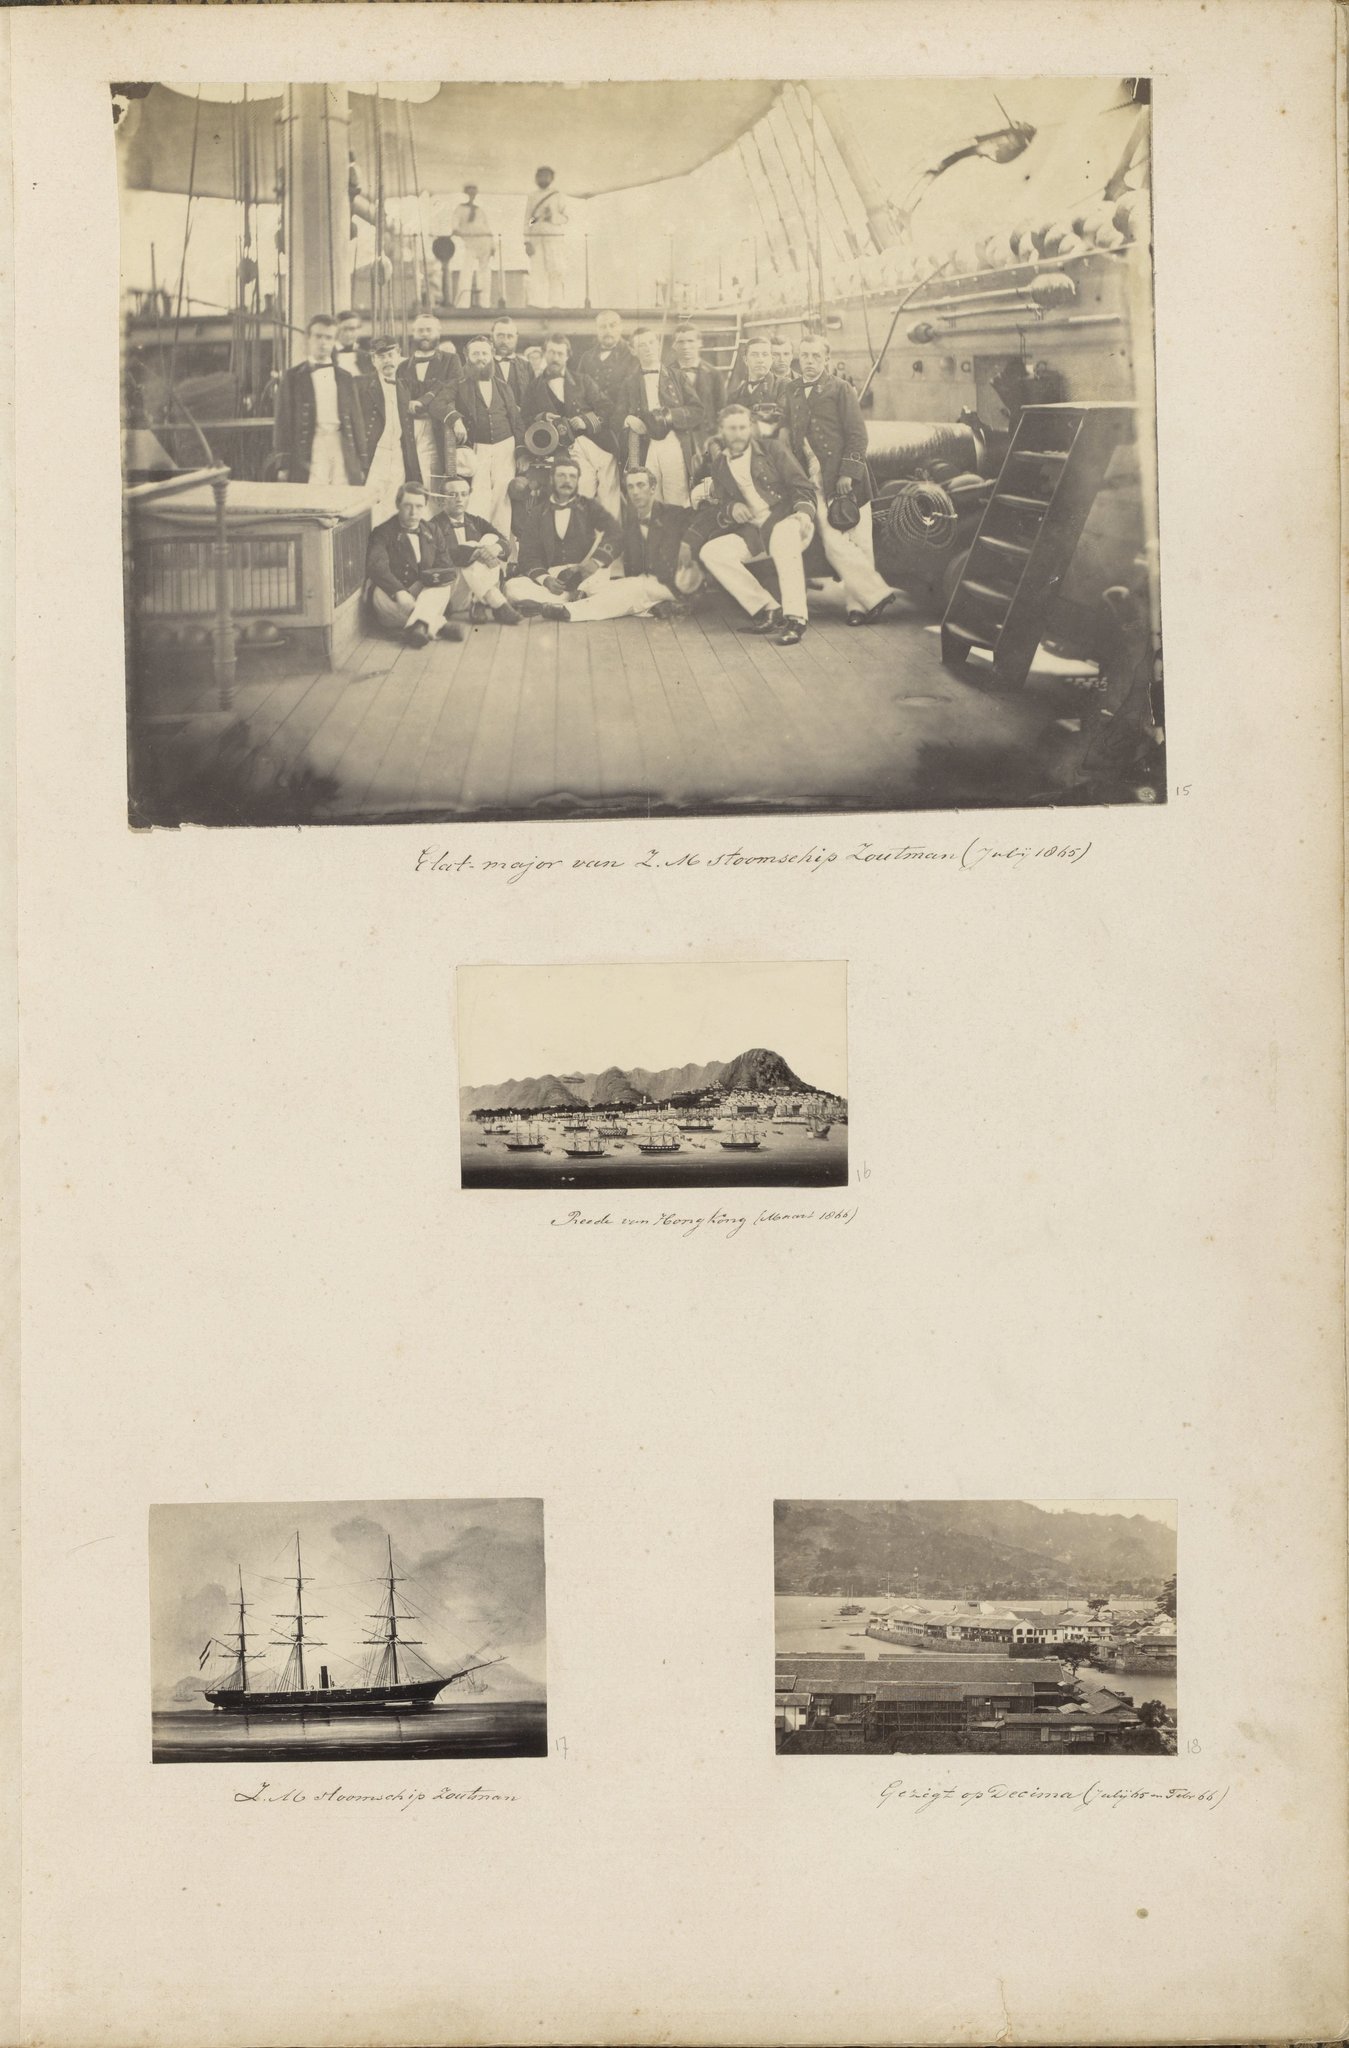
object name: album leaf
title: Etat-major aan dek van Z.M. stoomschip 'Zoutman'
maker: Anonymous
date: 1807-1865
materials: paper, photographic support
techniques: albumen print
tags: crew ~ ship, parts of ship's exterior: deck, sailing-ship, sailing-boat (with name), steamship, motorship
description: Op een los in het album aangetroffen strook papier worden de personen aangeduid als (staand van links naar rechts) Dronkers, Van Loon, Crommelin, Boelen, Gouwe, Kamp, Lamie, Keus en Kraaienhof, Cornelissen, Heffeling, Van der Wijk en (zittend v.l.n.r.) Horner, Damme, Doorman, Vinkhuyzen, Joekes. Onderdeel van Fotoalbum van Robert Daniel Crommelin (1841-1907).